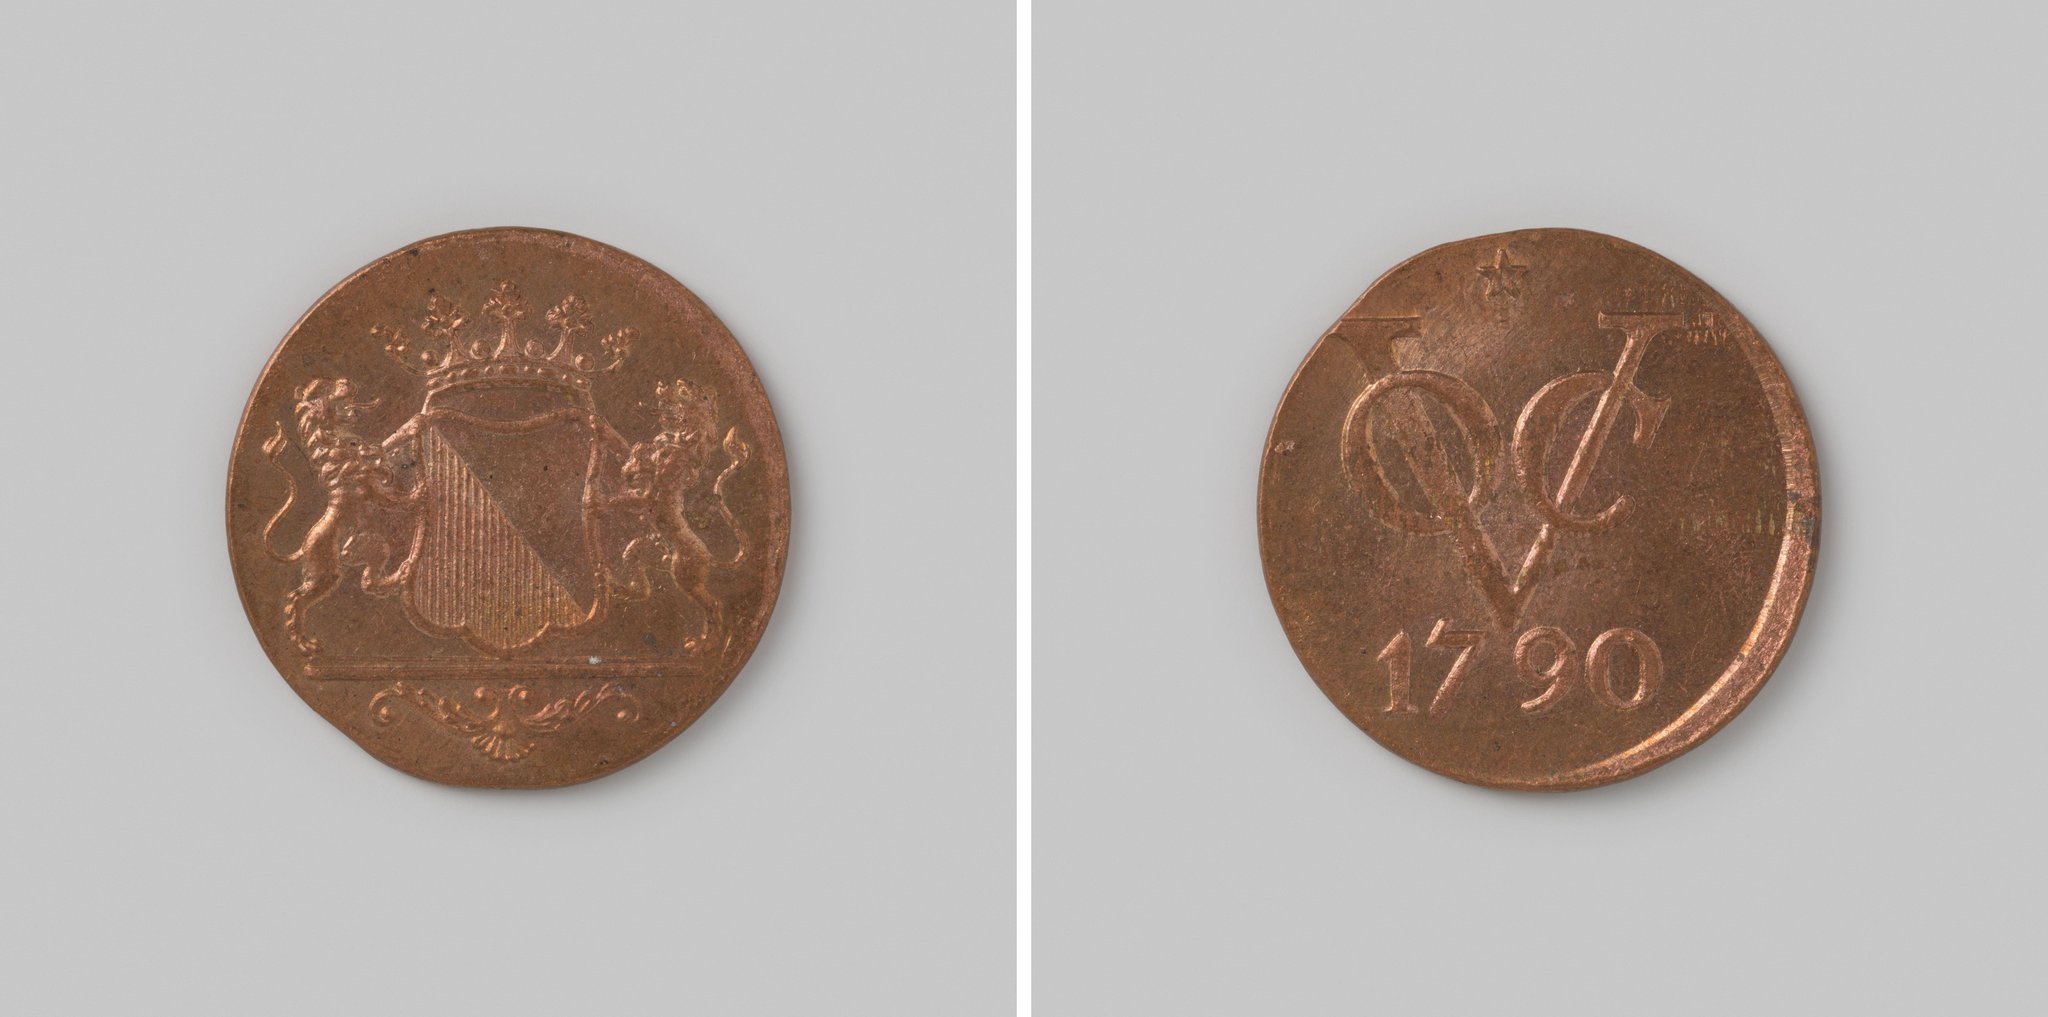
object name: coin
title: Dubbele duit op naam van de VOC en de stad Utrecht met jaartal1790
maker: william ii of the netherlands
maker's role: koning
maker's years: 1792-1849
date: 1840-1843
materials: copper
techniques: striking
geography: surabaya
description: Koperen munt. Voorzijde: op balk, waaronder guirlande, staand, door twee leeuwen gehouden gekroond wapenschild van de stad Utrecht. Keerzijde: monogram van de VOC, waarboven muntteken ster en waaronder fictief jaartal 1790. Gladde rand.